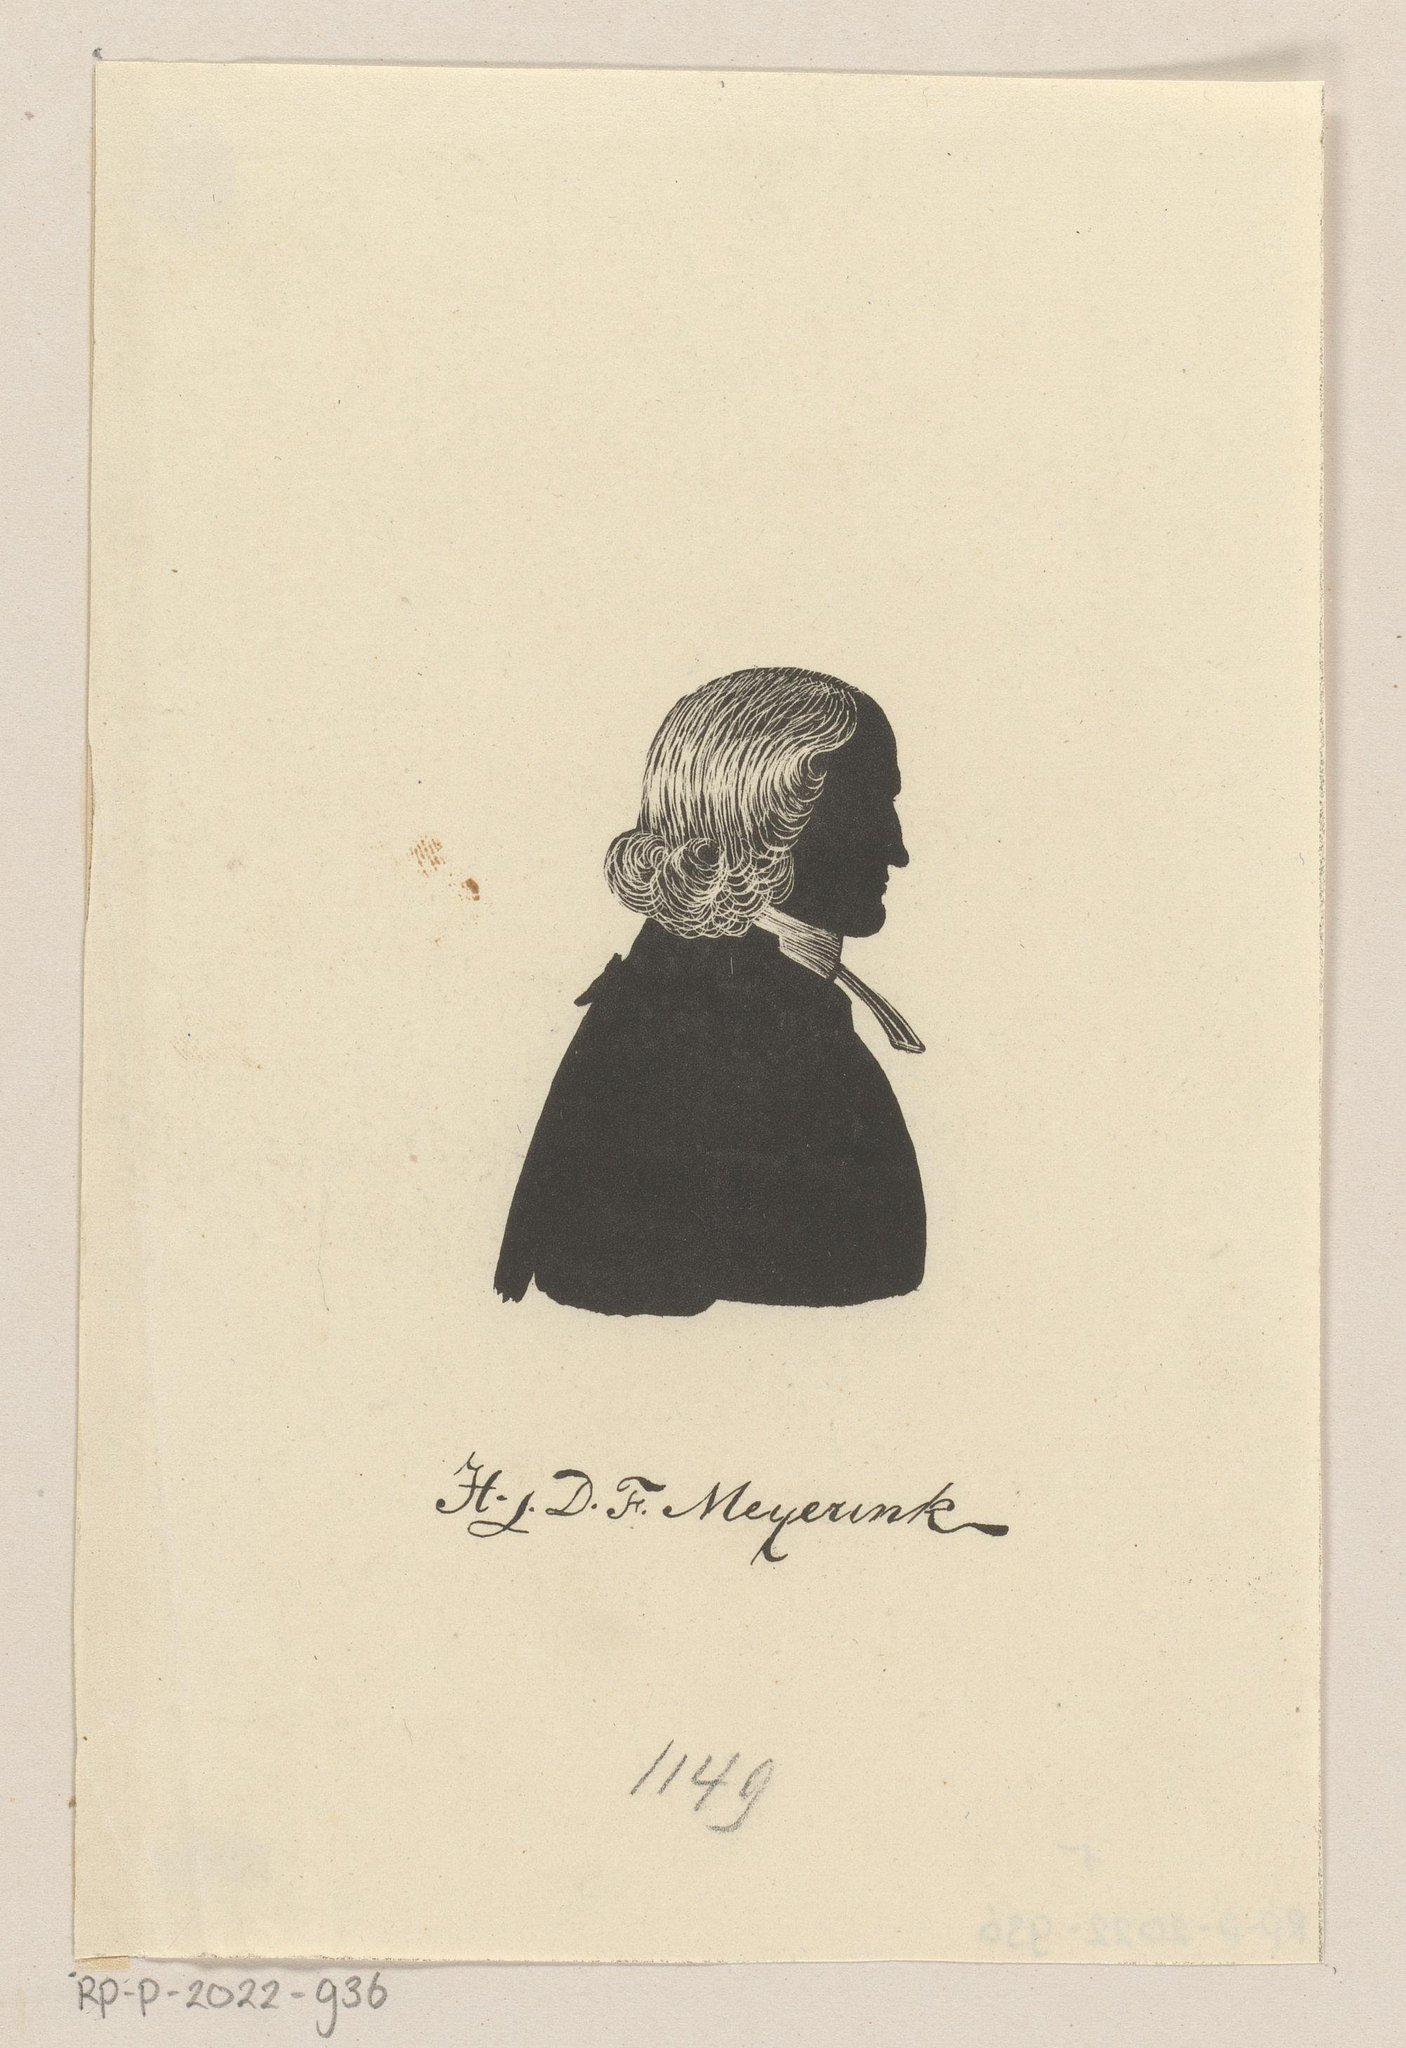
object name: print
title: Portret van Hier. Jan. Da. Fr. Meijerinck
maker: Anonymous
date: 1800-1900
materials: paper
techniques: engraving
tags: historical persons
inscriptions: number: ‘1149’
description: Met facsimile signatuur van de geportretteerde.